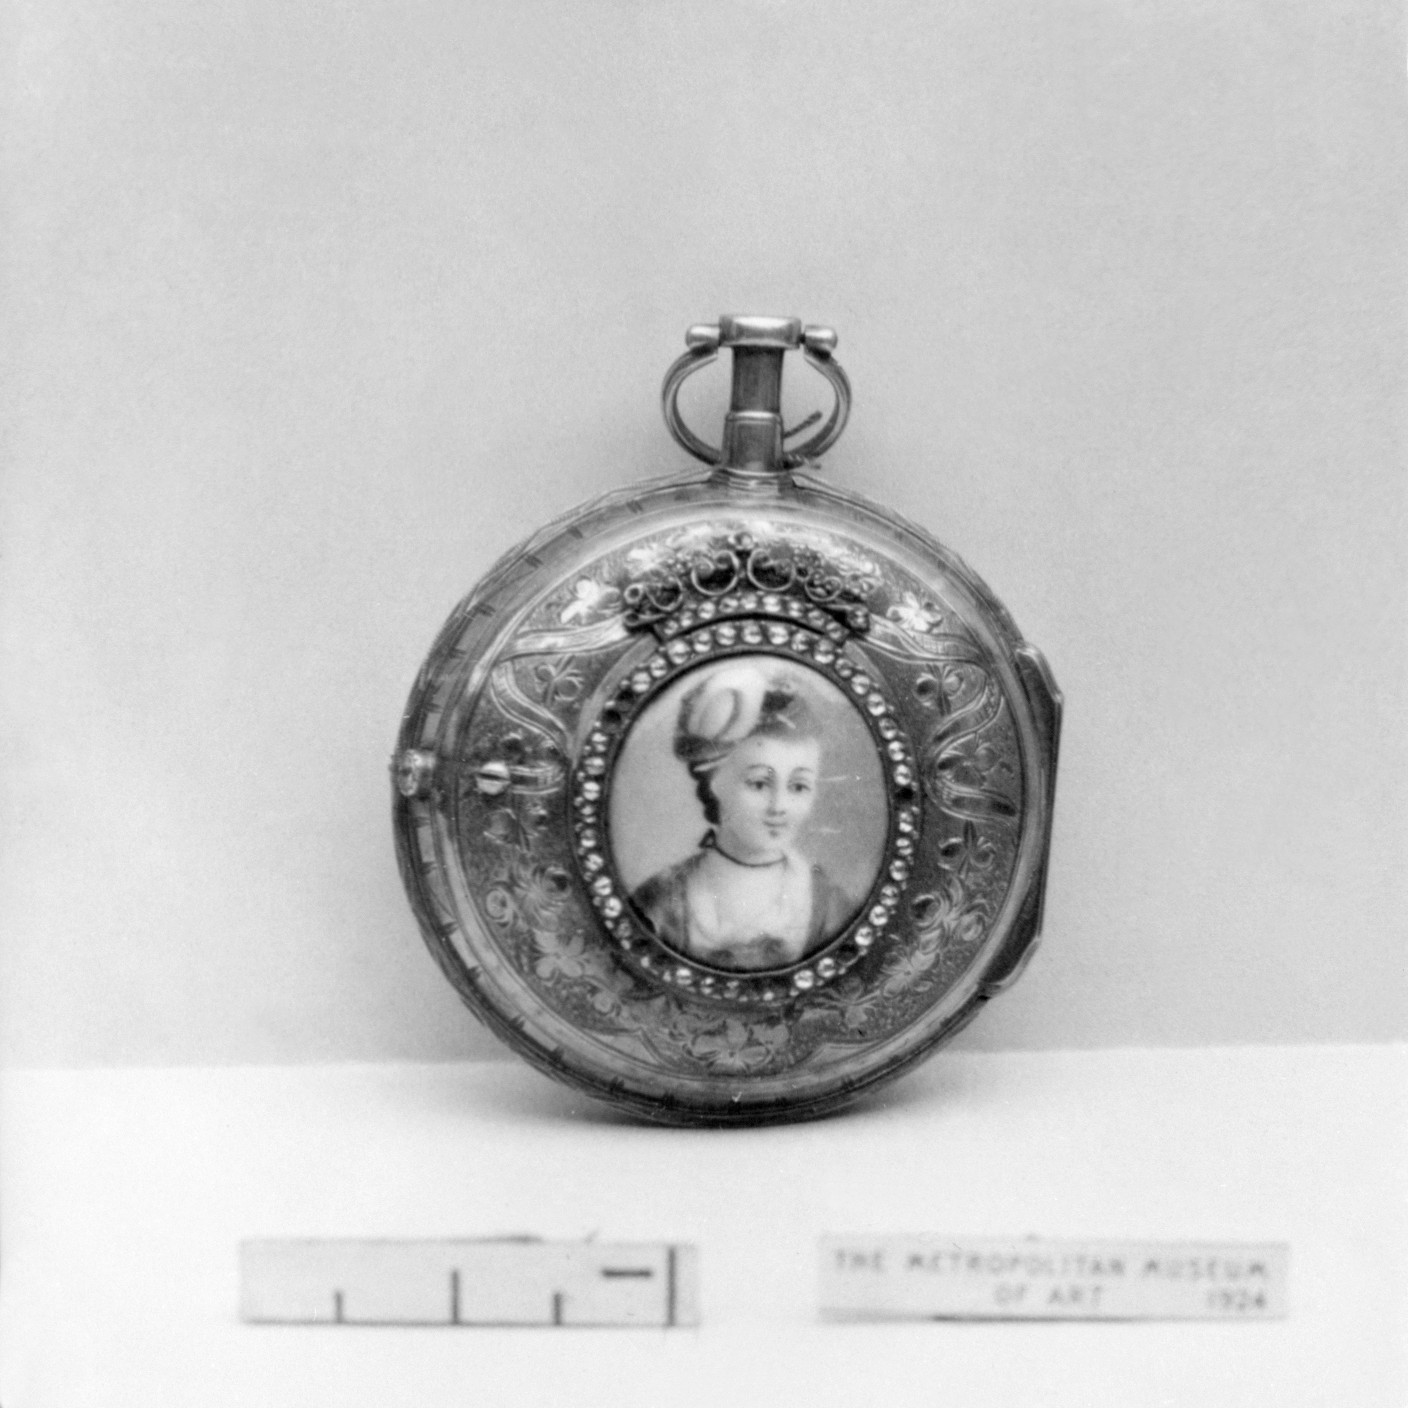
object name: watch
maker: jean antoine lépine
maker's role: maker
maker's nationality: french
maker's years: 1720-1814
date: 1751-1800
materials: brass, crystal, enamel, gold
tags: portraits,women